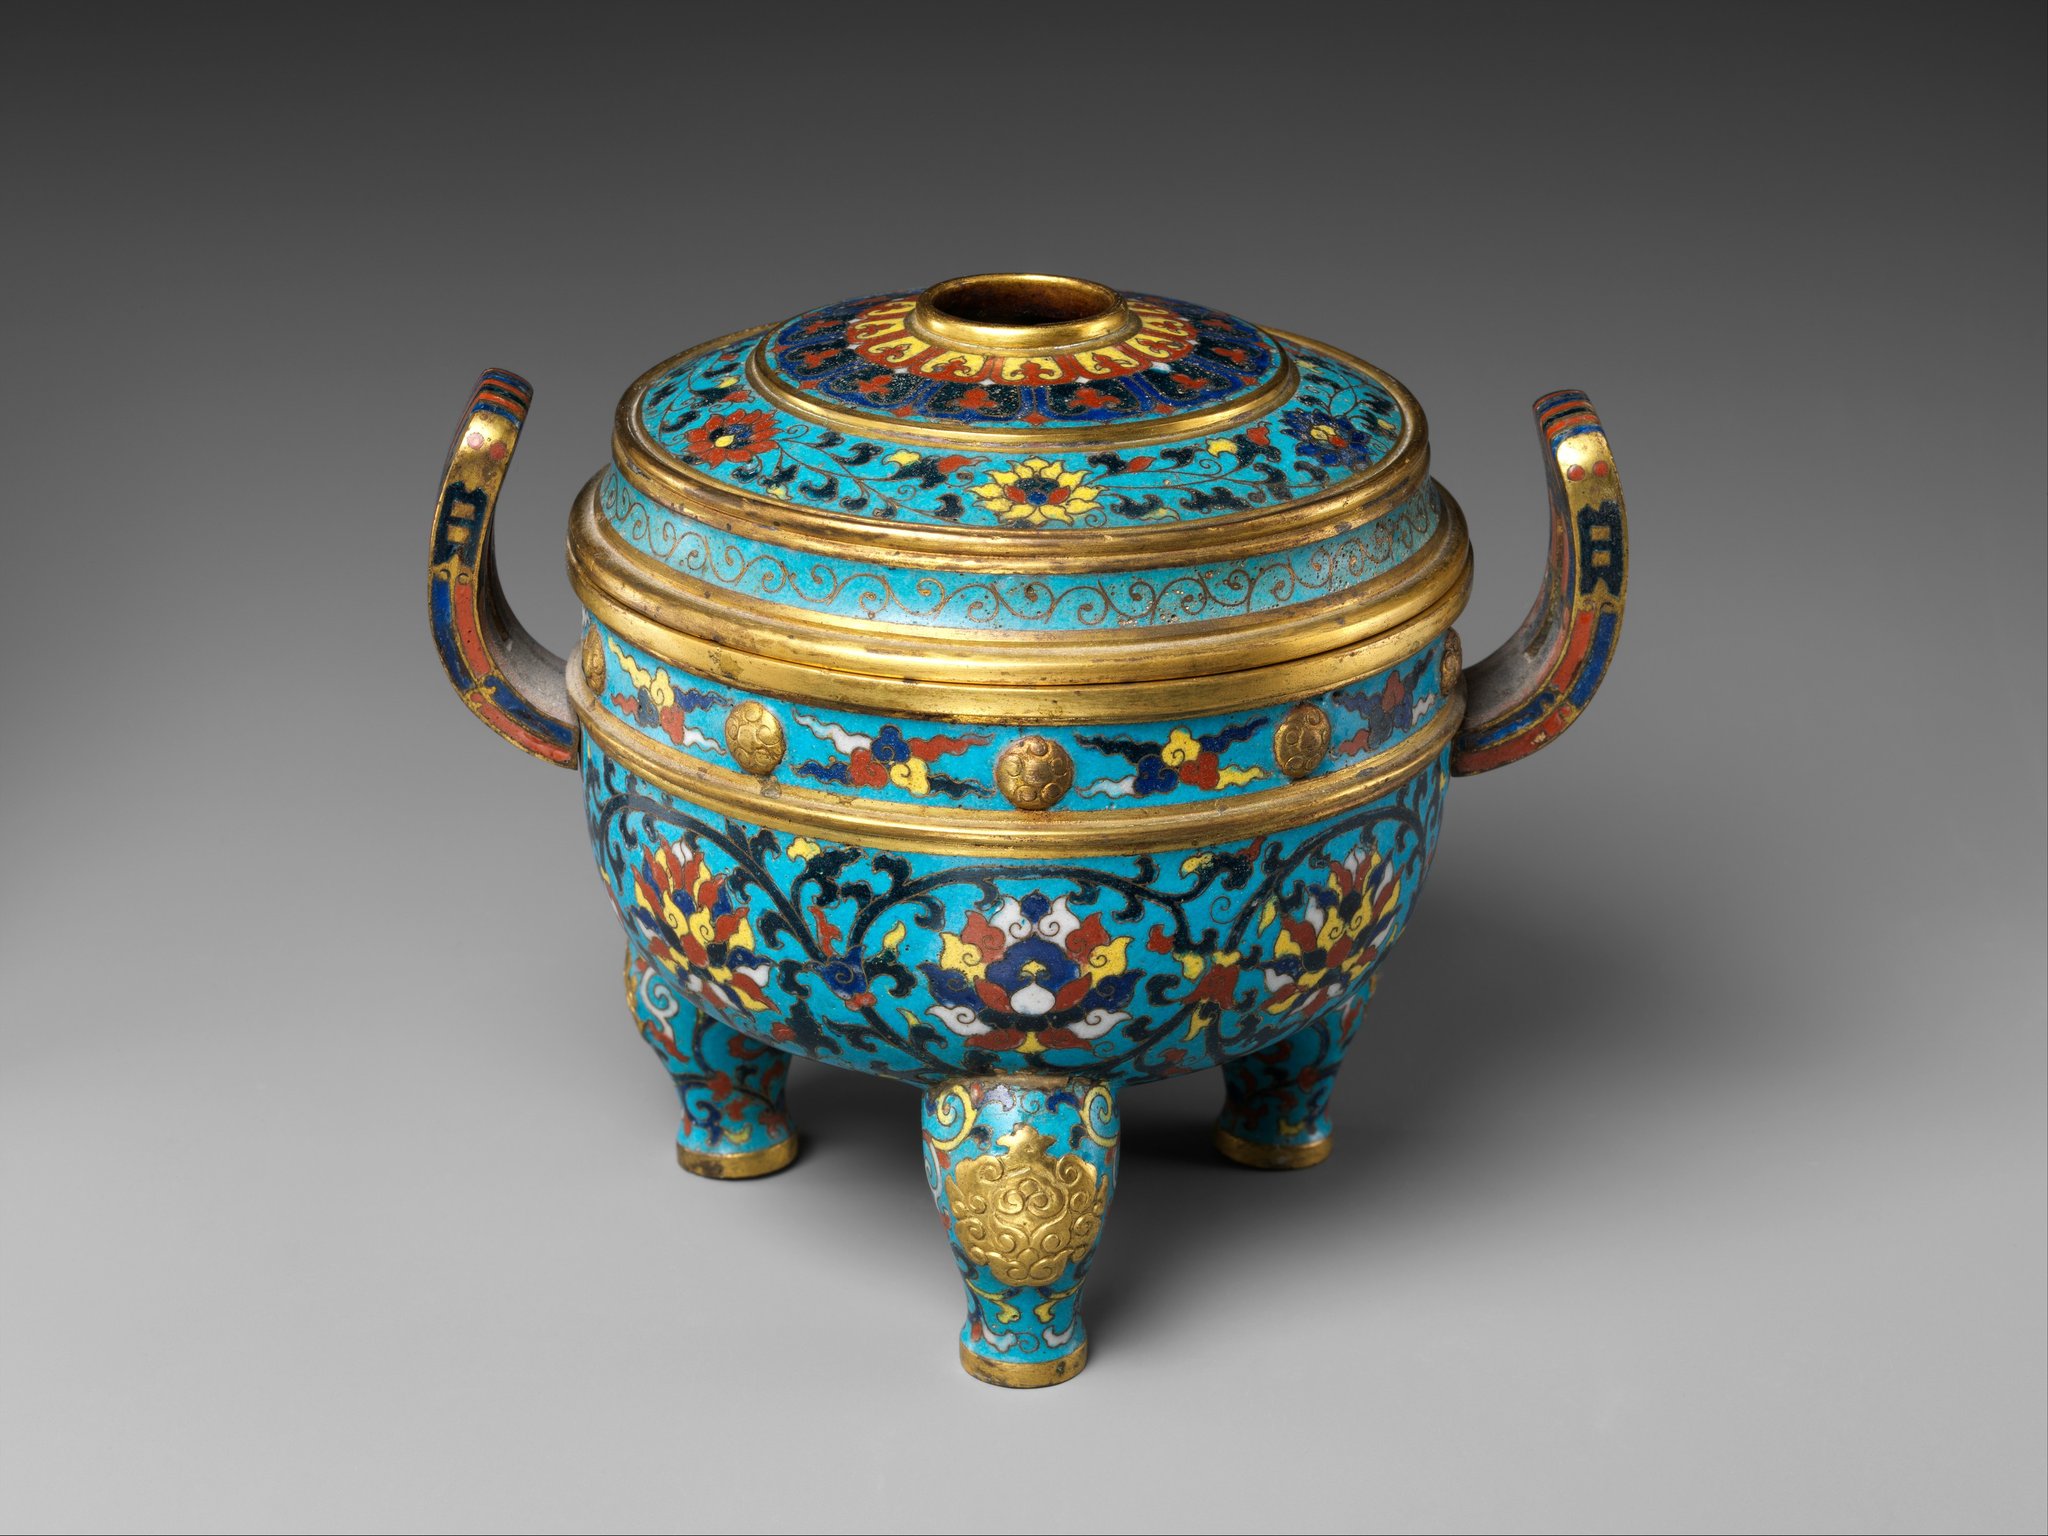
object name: incense burner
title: Tripod incense burner with lid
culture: chinese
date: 1401-1433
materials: enamel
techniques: enamel